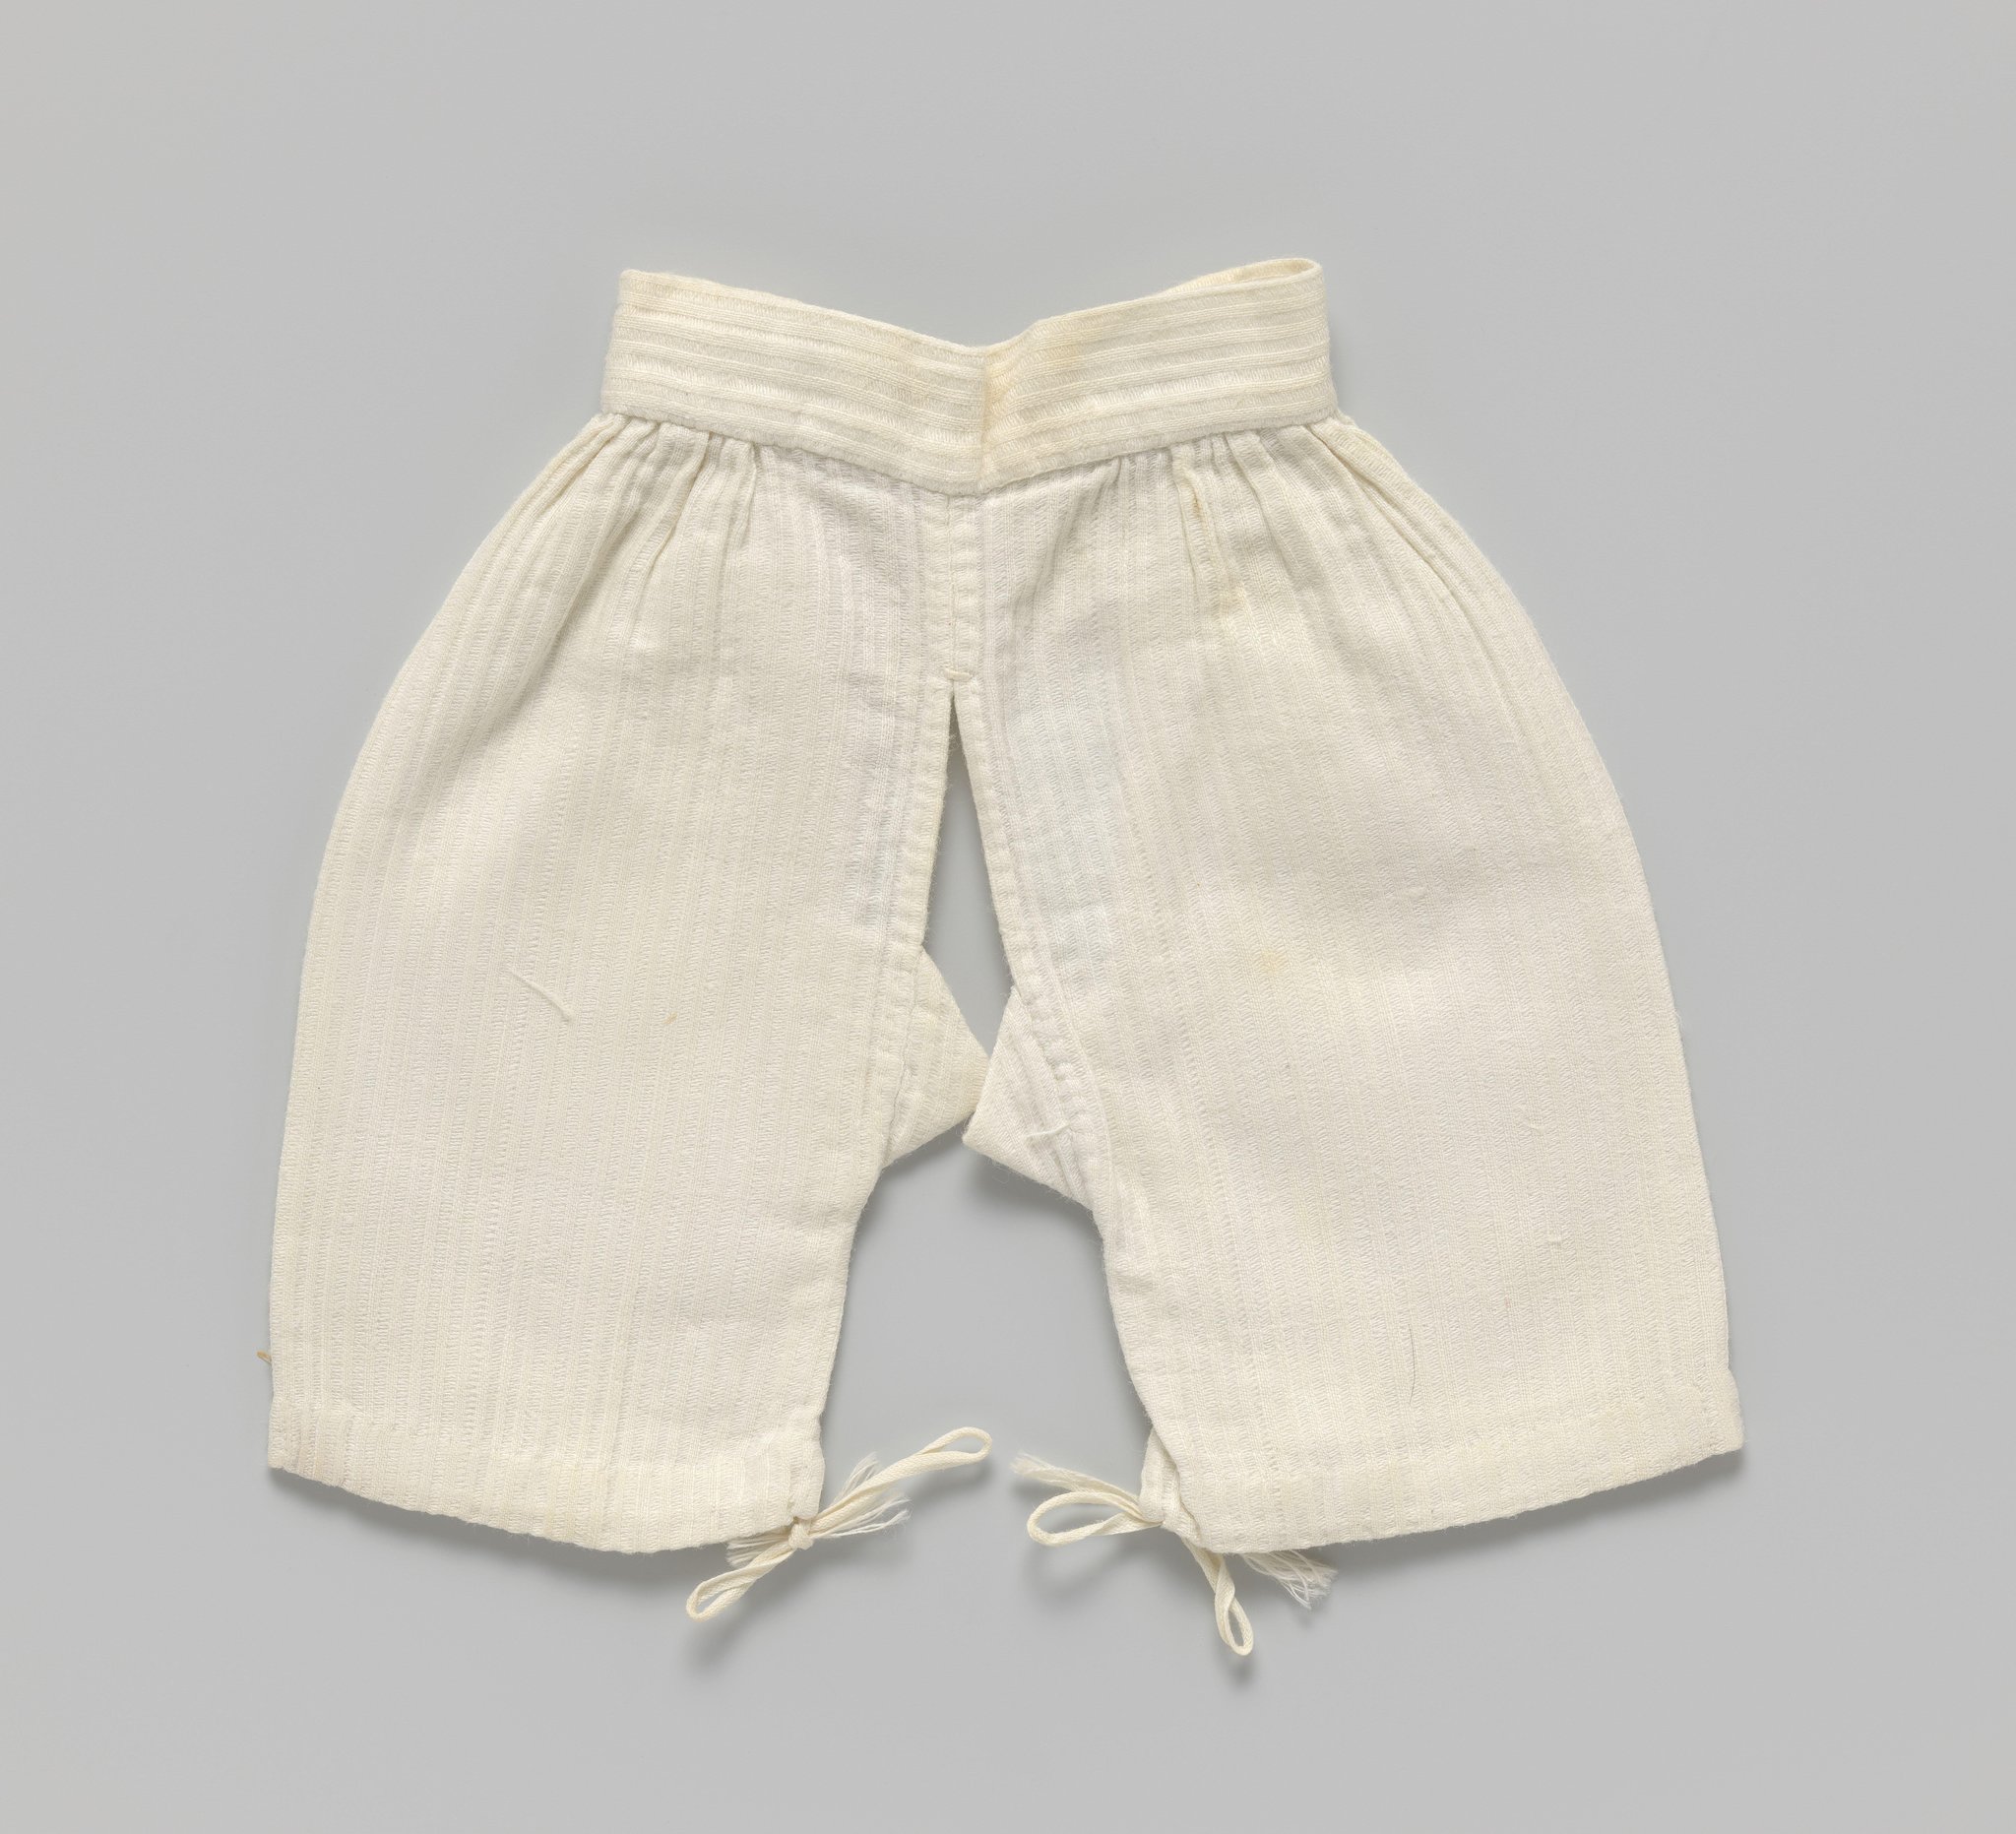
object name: doll's clothing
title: Onderbroek van wit katoen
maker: Anonymous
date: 1850-1920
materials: cotton, metal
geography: europe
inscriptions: number: ‘RBK 15445’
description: Het katoen heeft een ingeweven patroon van verticale strepen; aan het uiteinde van de pijpen een tunnel met gestrikt lint. Aan de achterzijde sluit de onderbroek met een haak van metaal.